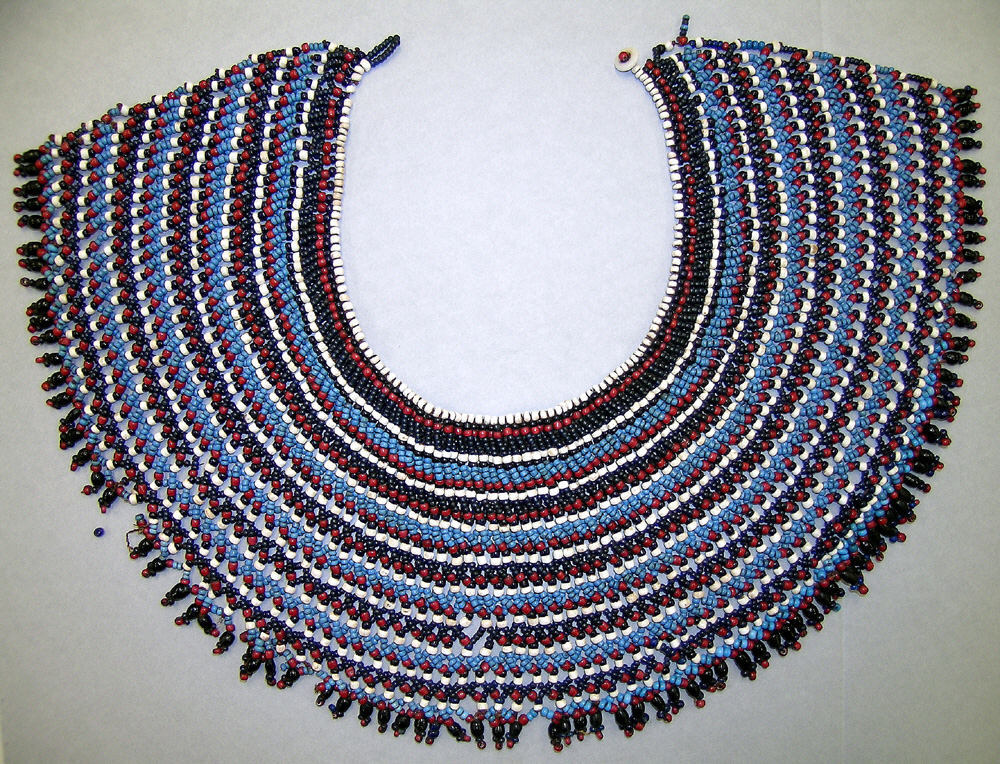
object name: collar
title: Collar (Ingqosha)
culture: mfengu or xhosa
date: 1870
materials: glass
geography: south africa